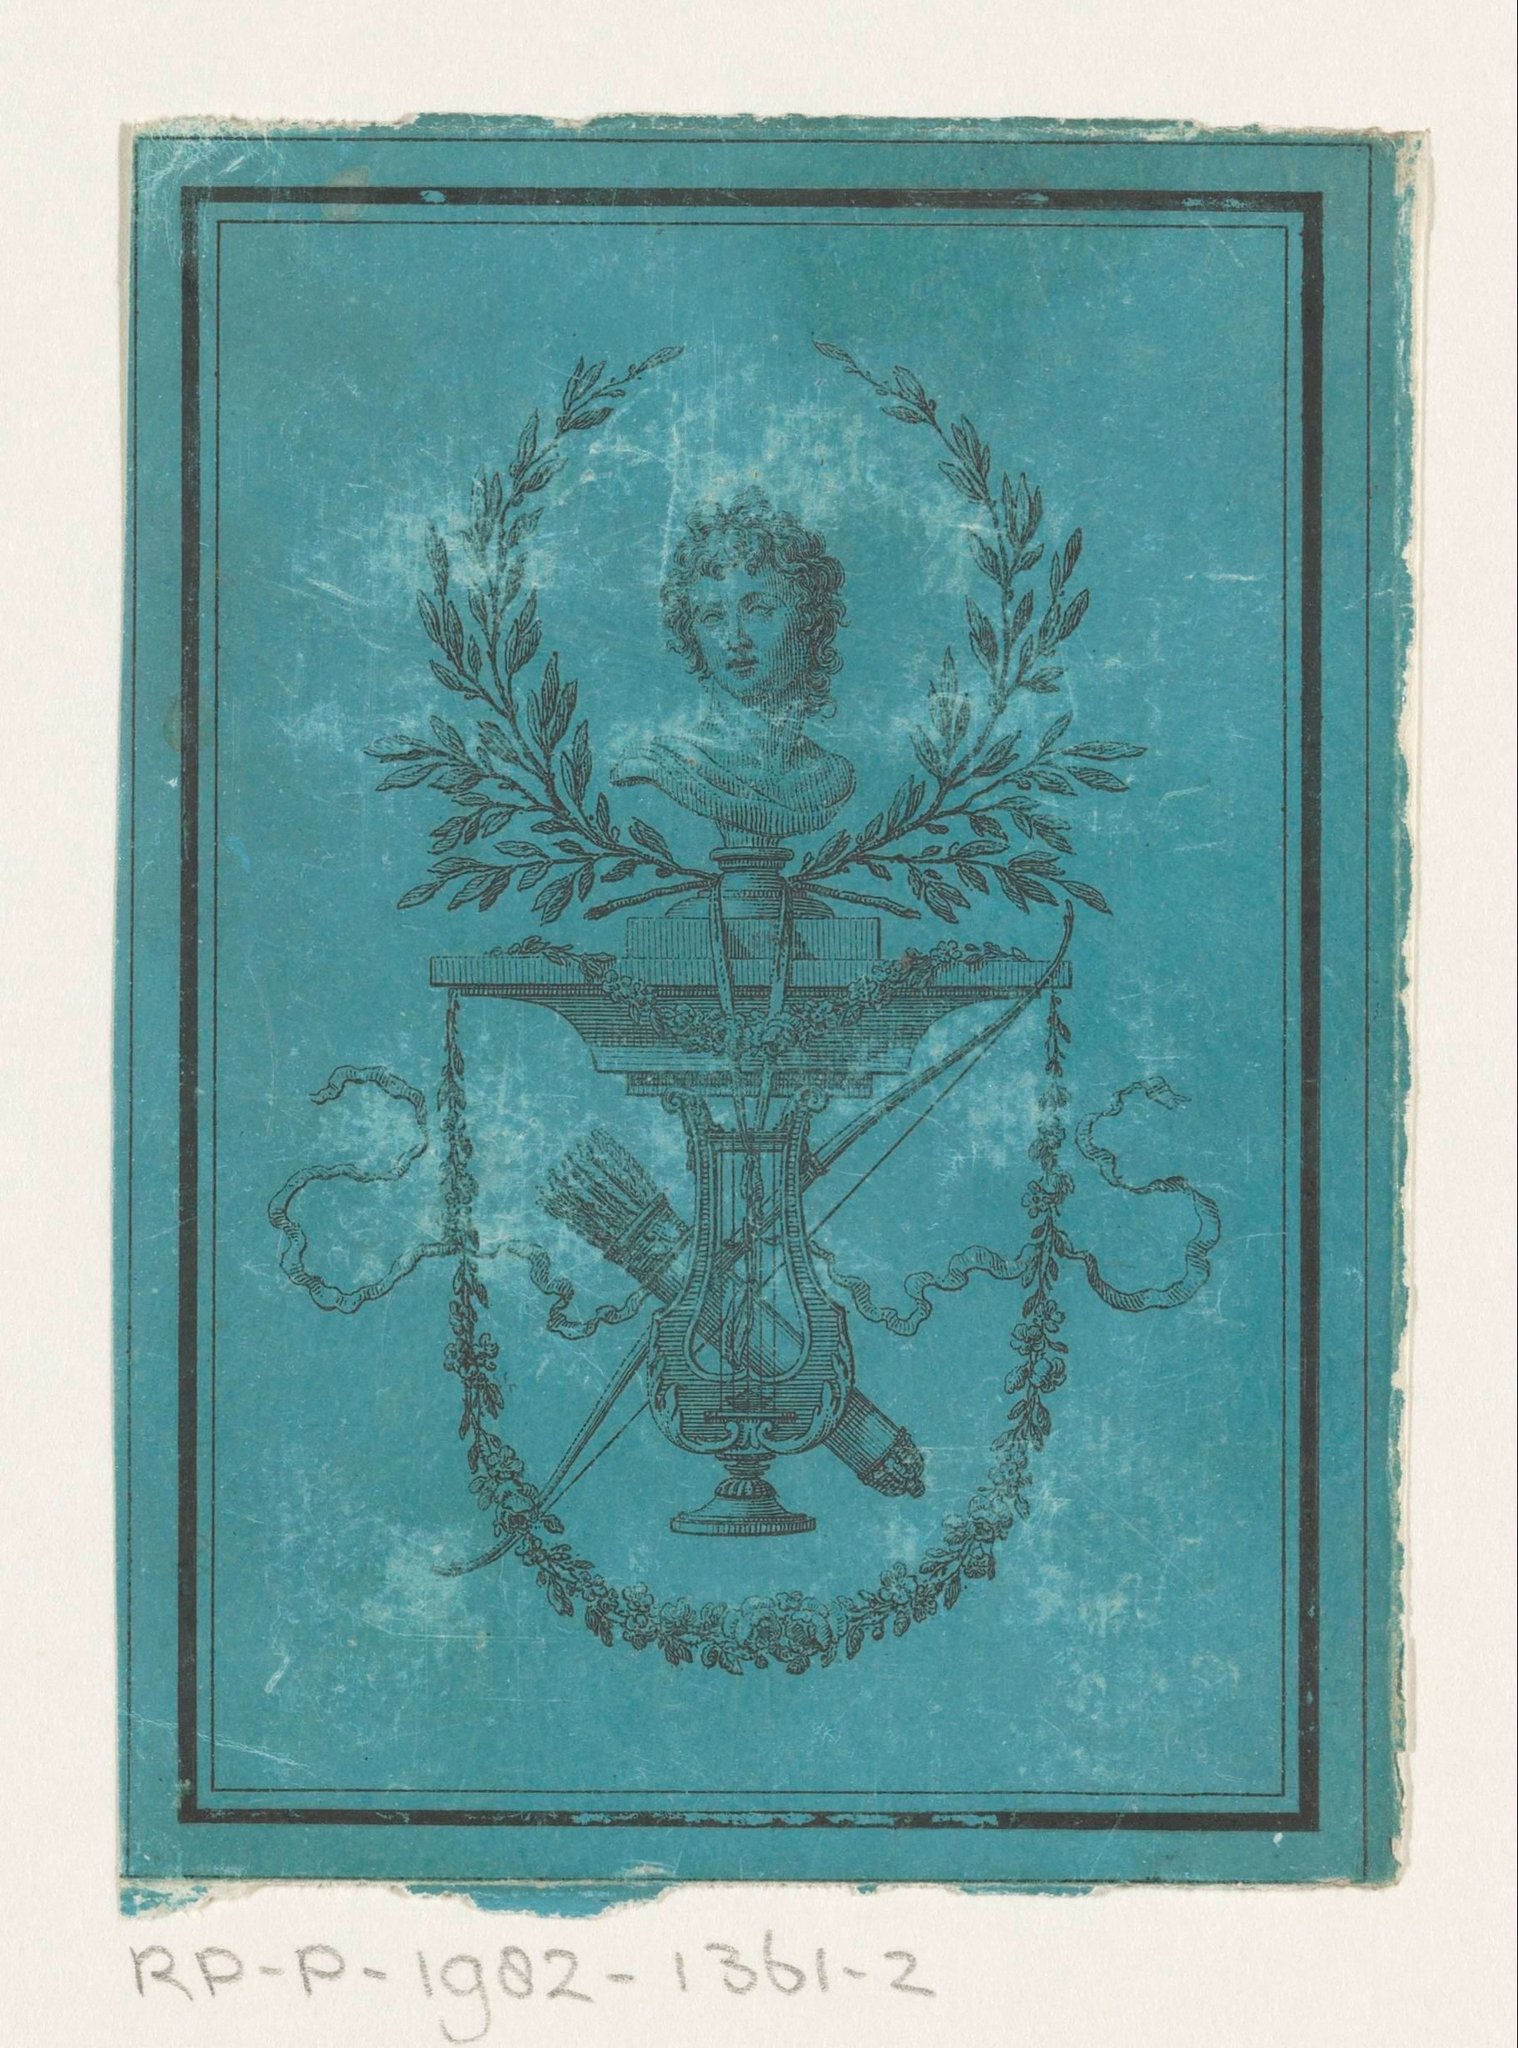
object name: print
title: Vignet met buste en lier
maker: Anonymous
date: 1821-1860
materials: paper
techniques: etching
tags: lyre, cithara, psaltery, piece of sculpture, reproduction of a piece of sculpture, vignette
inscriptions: collector's mark: Lugt 2760, collector's mark: Lugt 2228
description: Vignet met een buste op een voetstuk. Daaronder een lier, pijlenkoker en boog. In rechthoekige omlijsting.